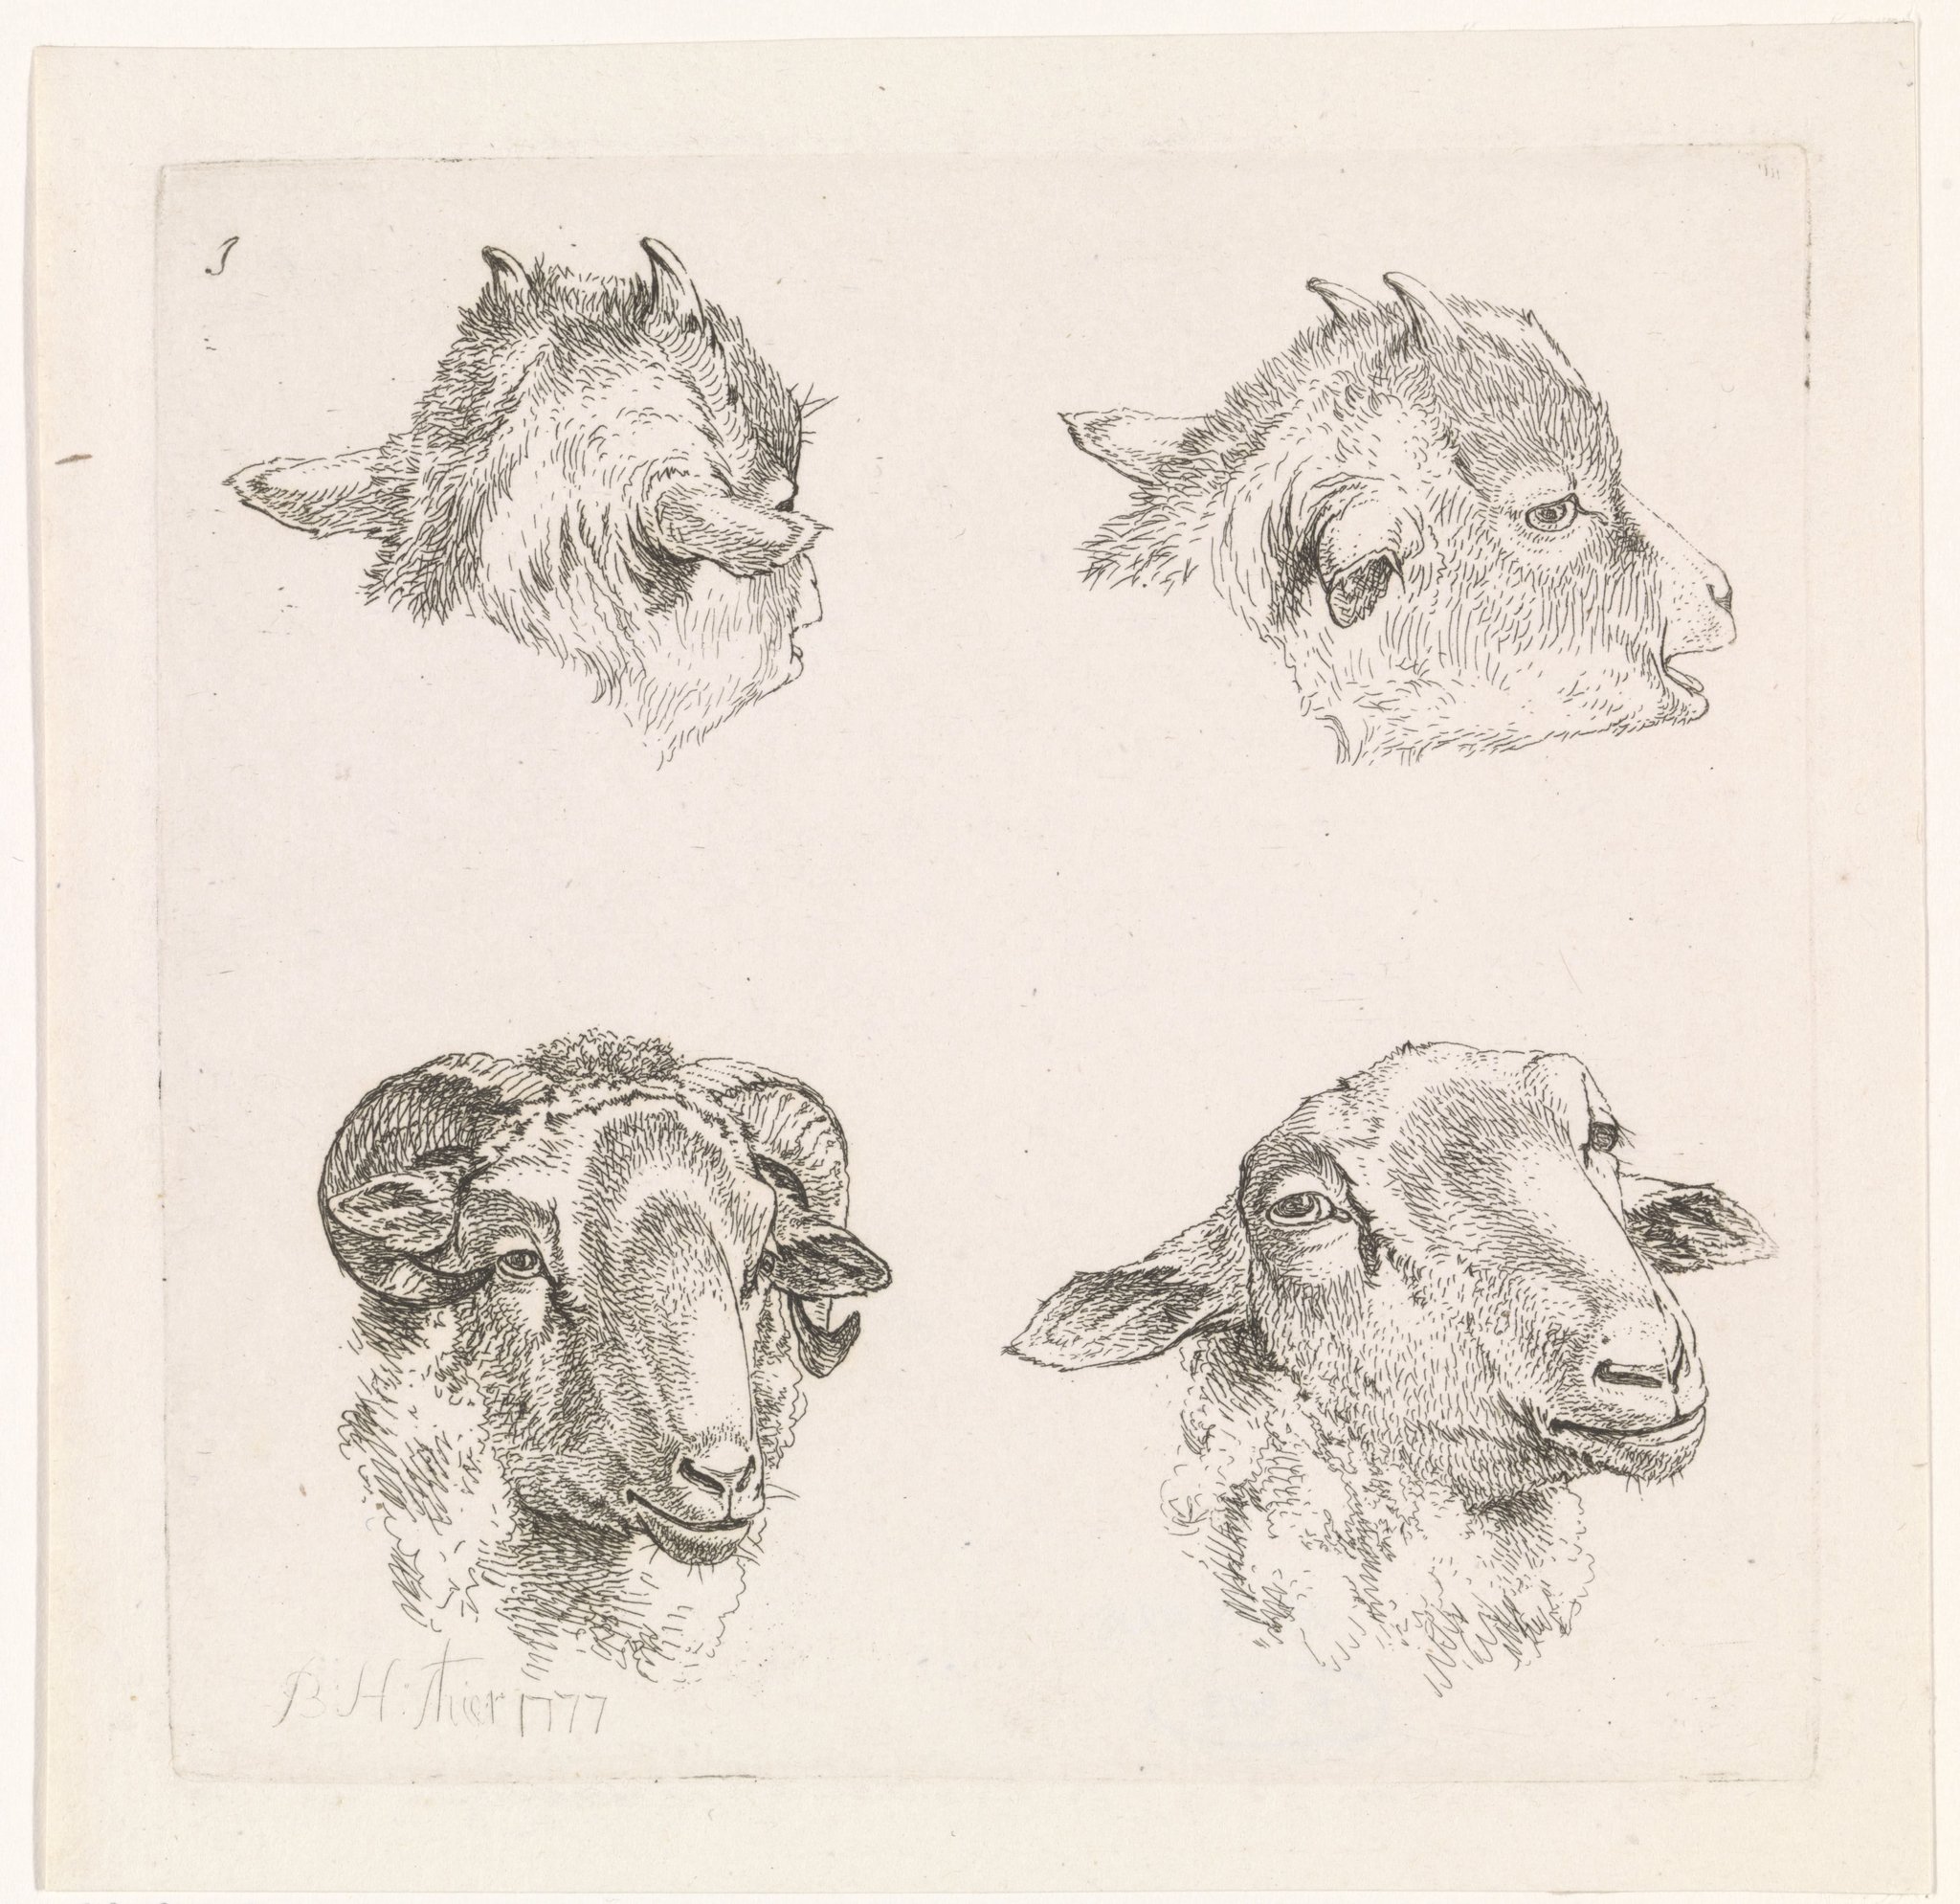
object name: print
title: Vier koppen, van geiten en een ram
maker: barend hendrik thier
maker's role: draughtsman, print maker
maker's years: 1743-1811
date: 1777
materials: paper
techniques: etching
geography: netherlands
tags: ram, goat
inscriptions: collector's mark: Lugt 2228